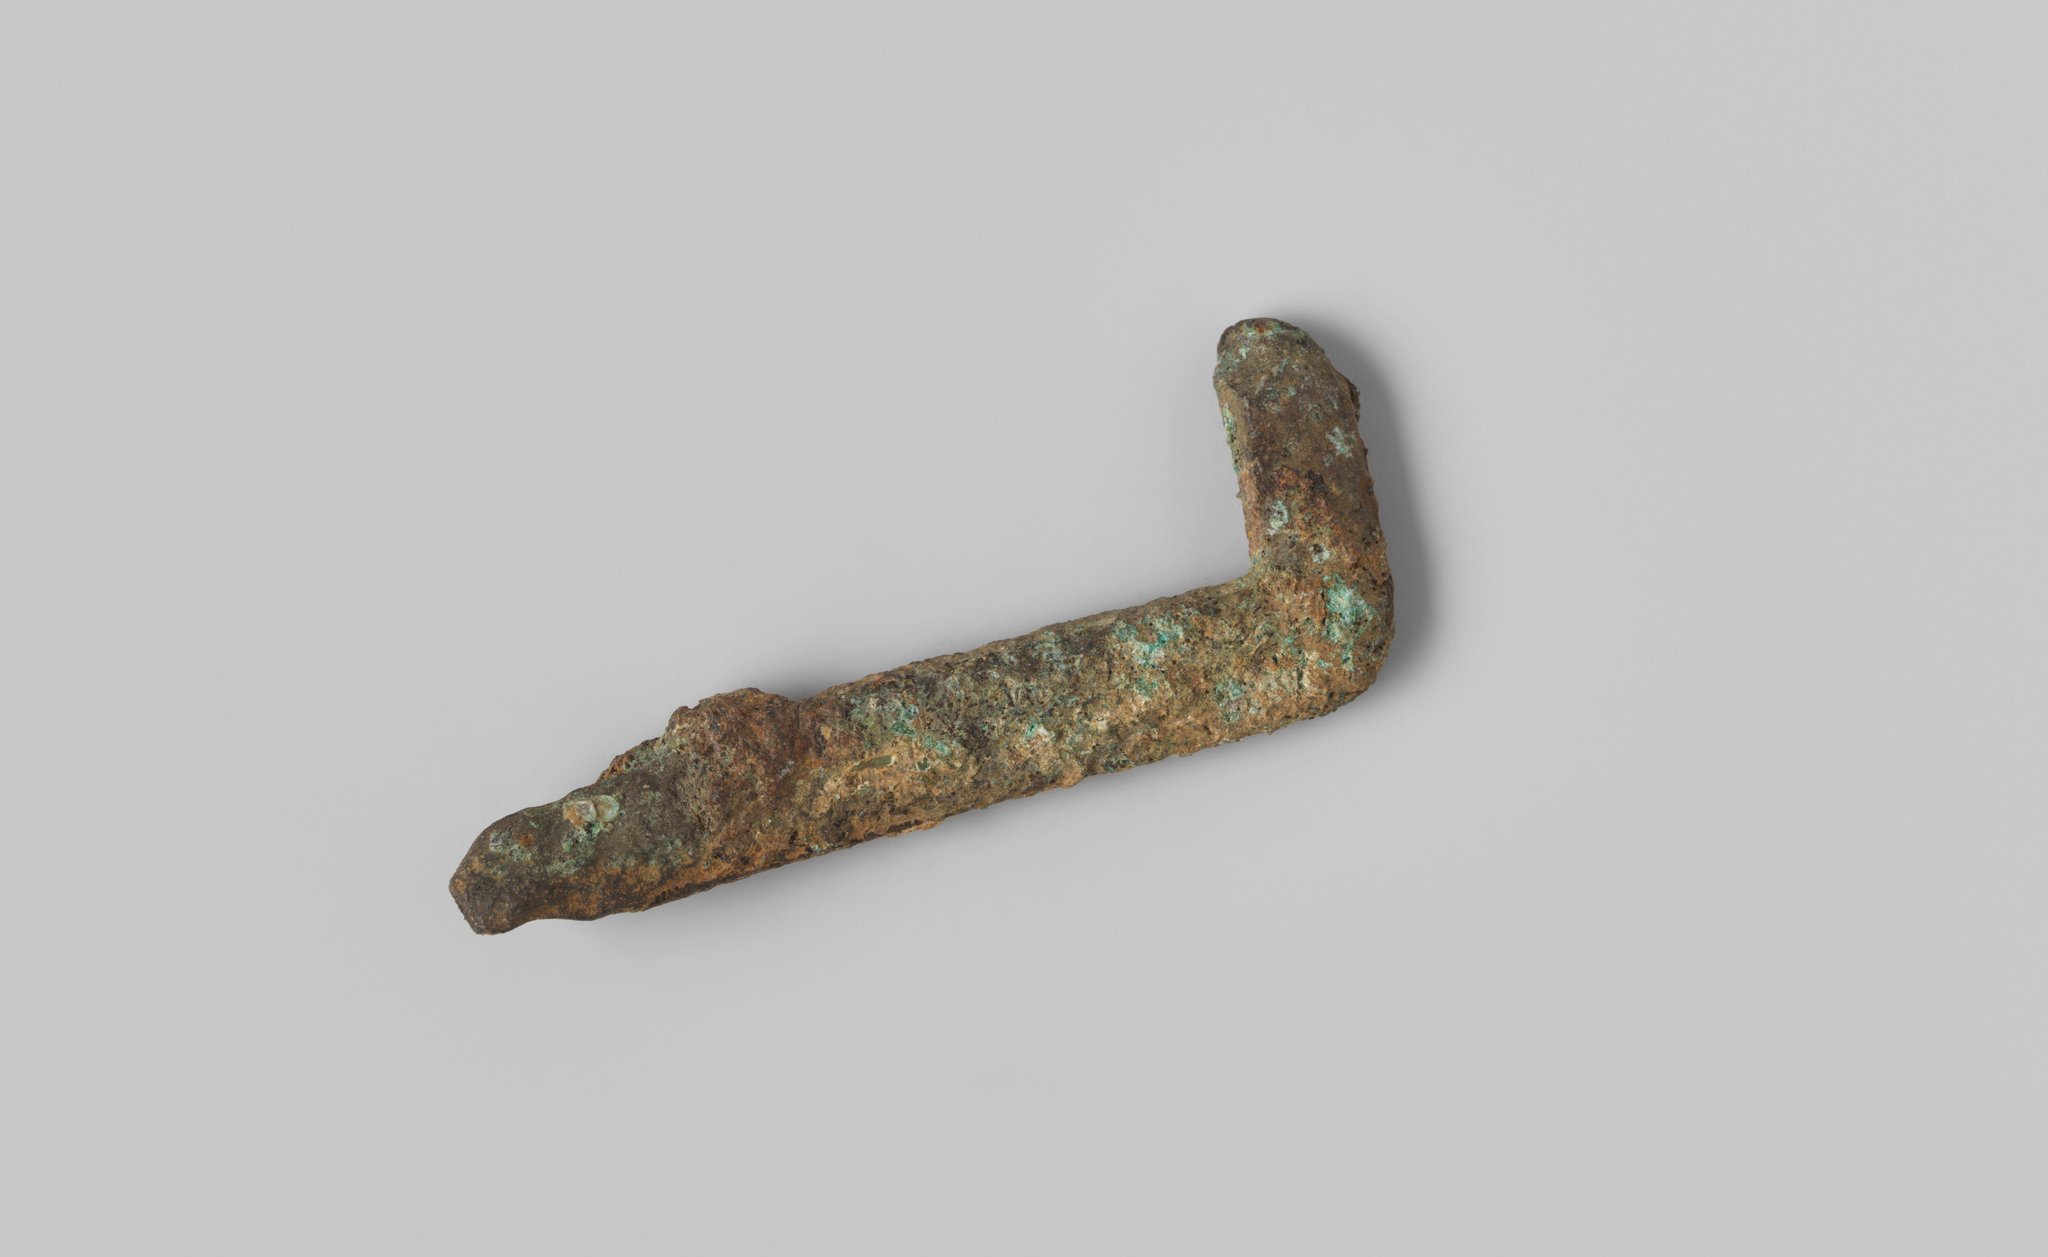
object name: belt buckle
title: Fragment riemgesp uit het wrak van de Oost-Indiëvaarder Hollandia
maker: Anonymous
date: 1700-1743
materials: copper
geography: netherlands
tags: verenigde oostindische compagnie, hollandia (schip), annet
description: Rectangular, fragm of ring, id. NG 1980-27H2852, belt buckle.